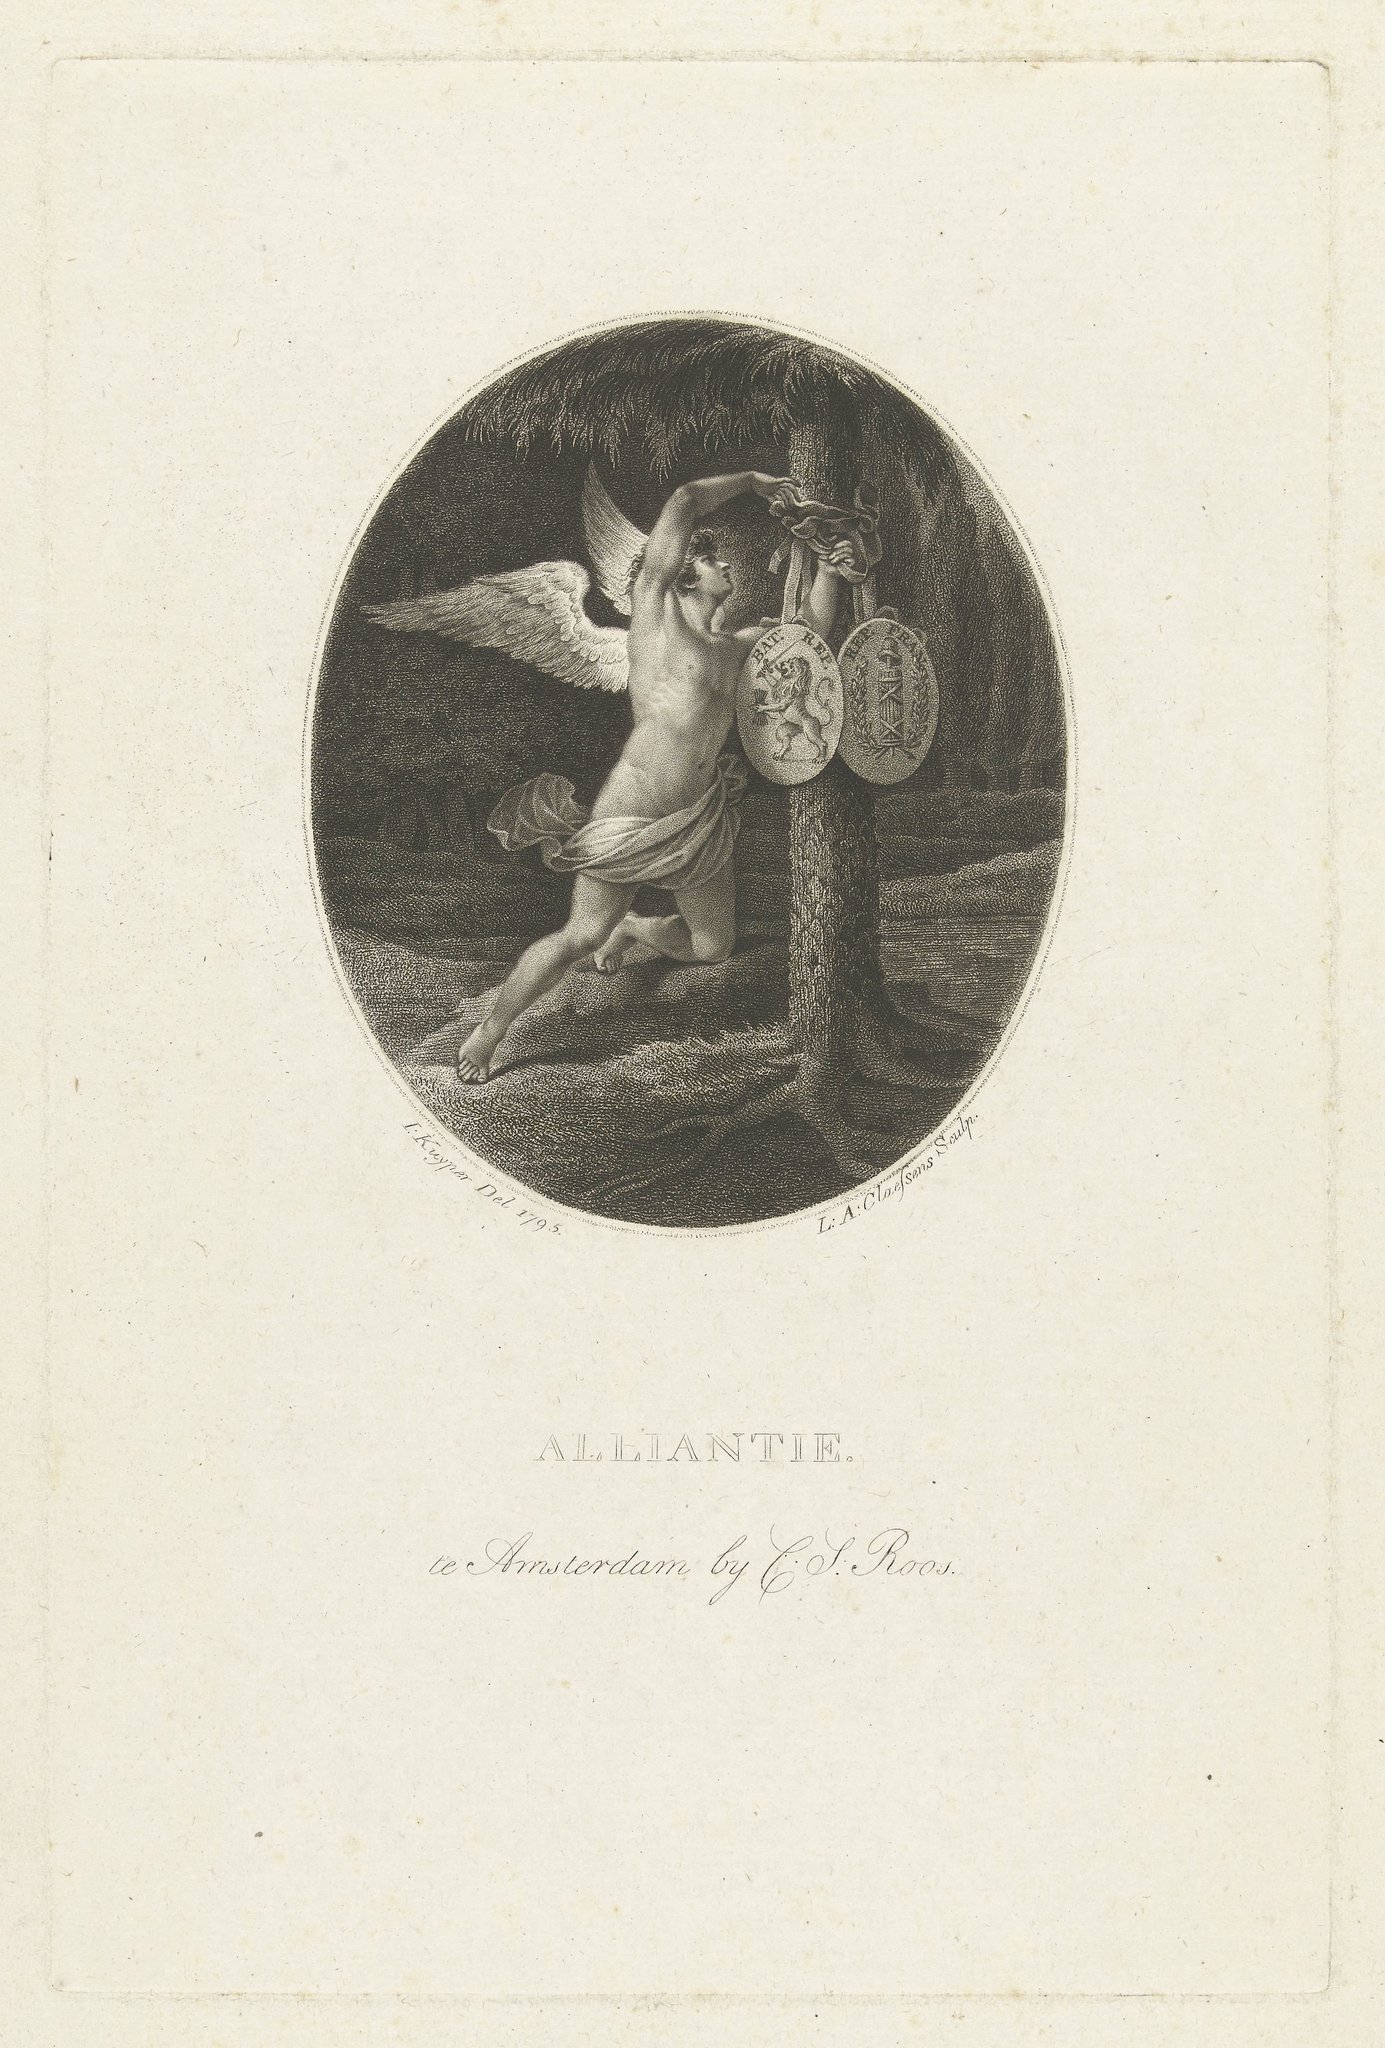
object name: print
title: Alliantie tussen Nederlandse en Franse republiek, 1795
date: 1795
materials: paper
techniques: etching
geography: amsterdam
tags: angels, alliance with france (1795)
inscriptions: collector's mark: Lugt 2228, date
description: Een engel bindt de wapens van de Nederlandse en Franse Republiek samen aan een boom.